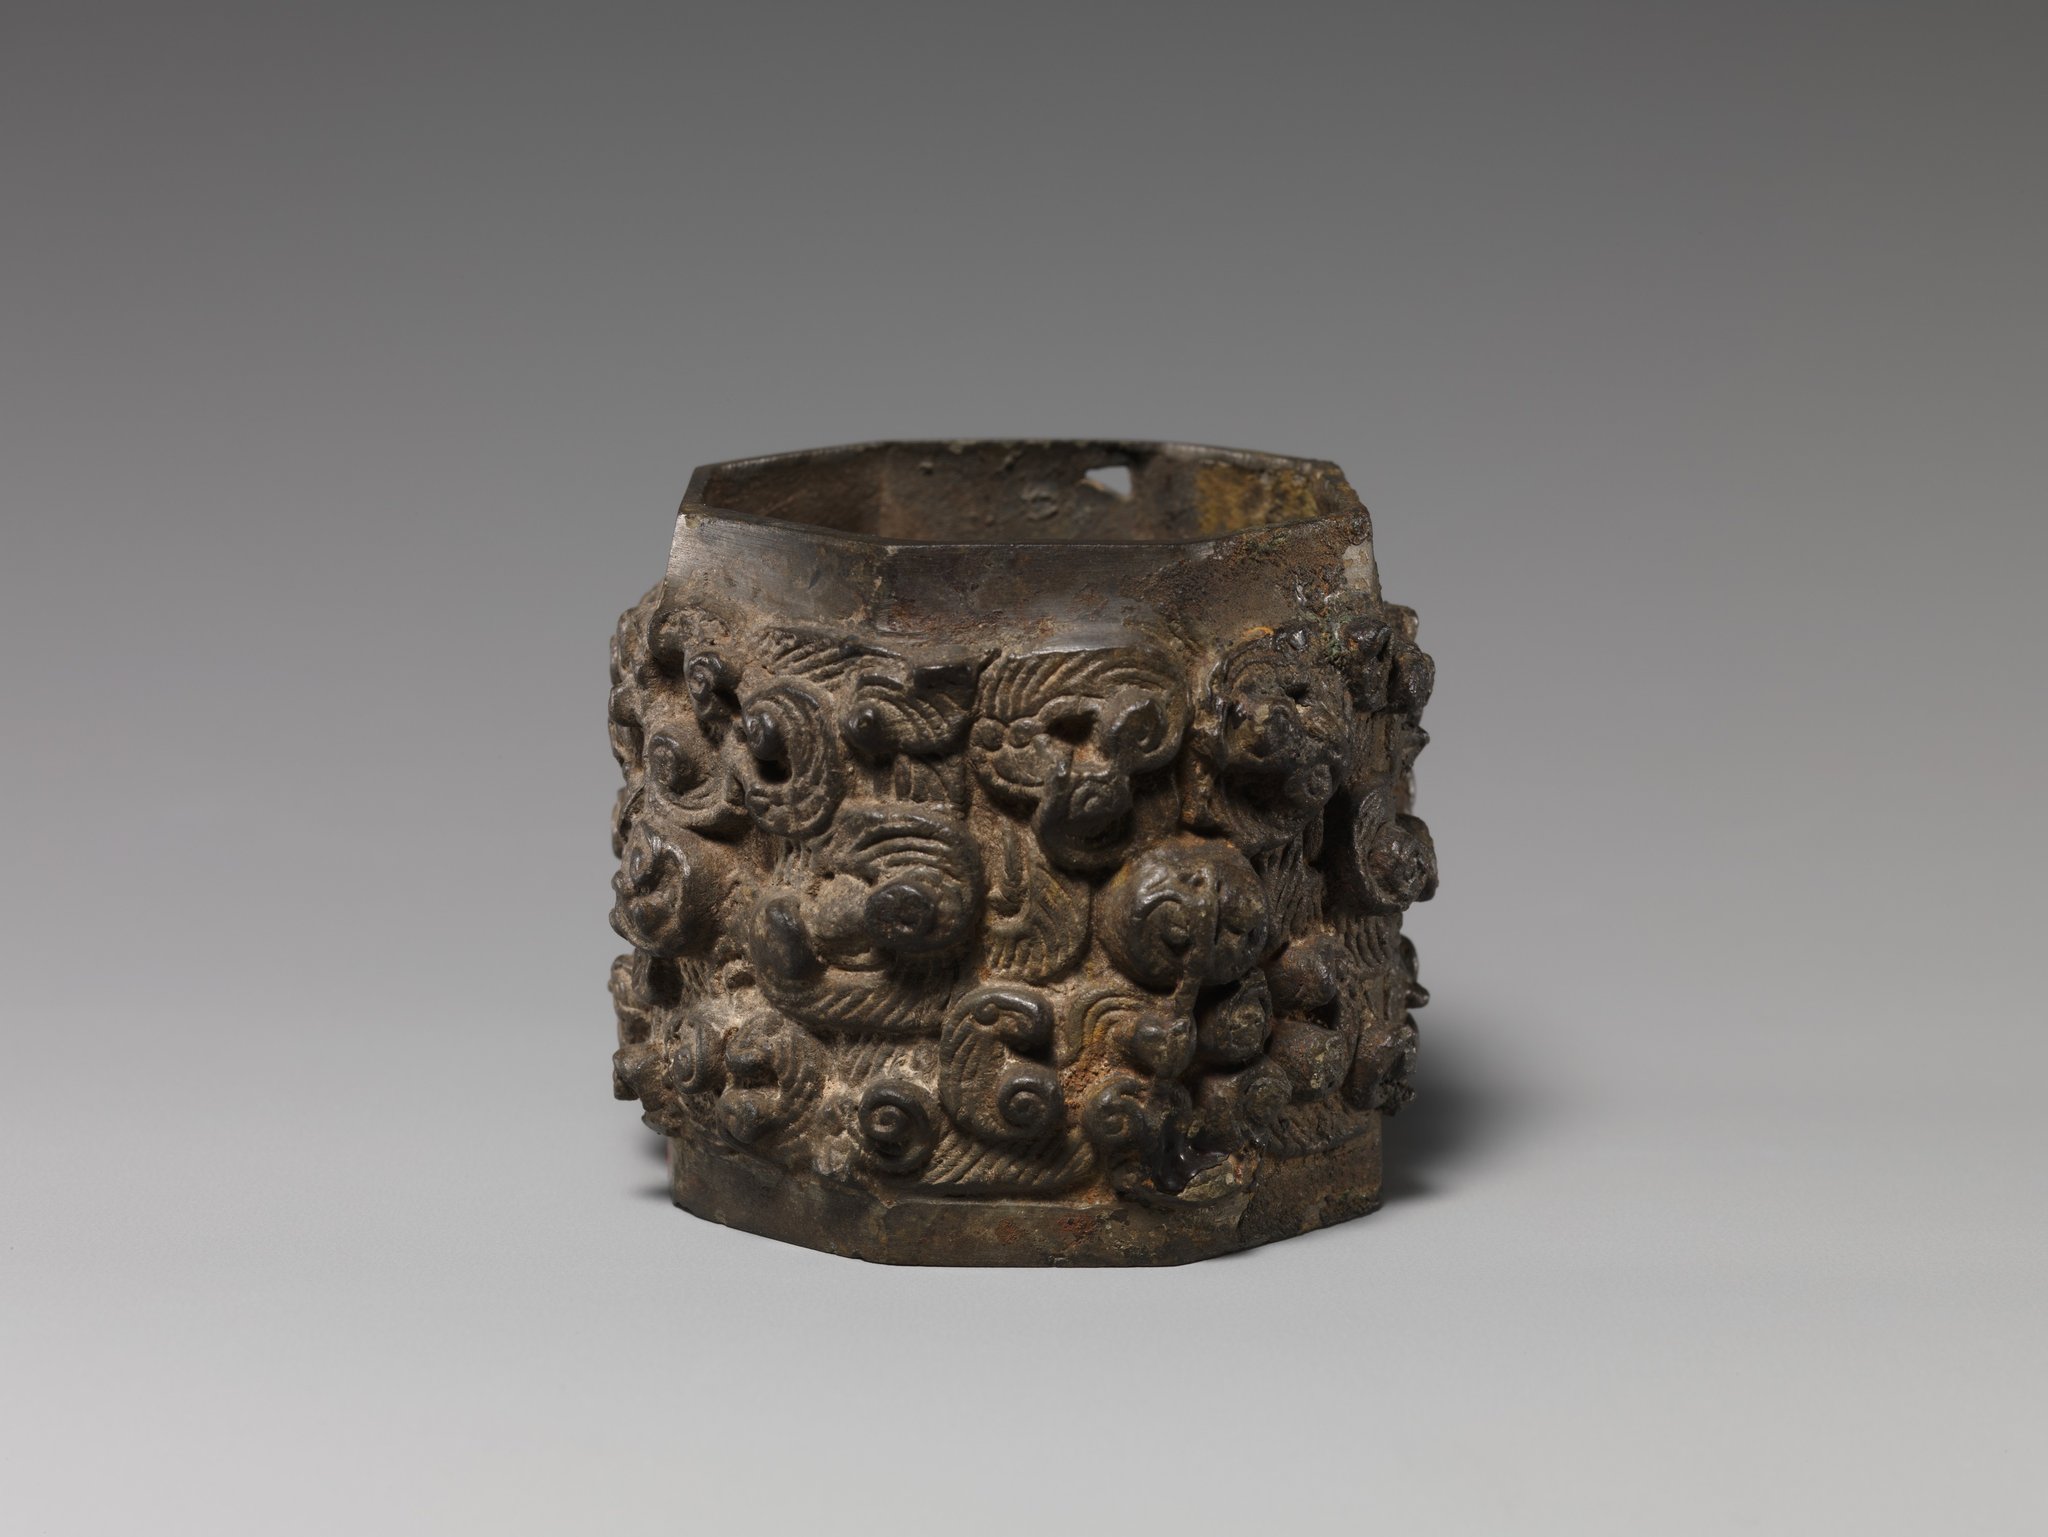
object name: ring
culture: chinese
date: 221-206 BCE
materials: bronze